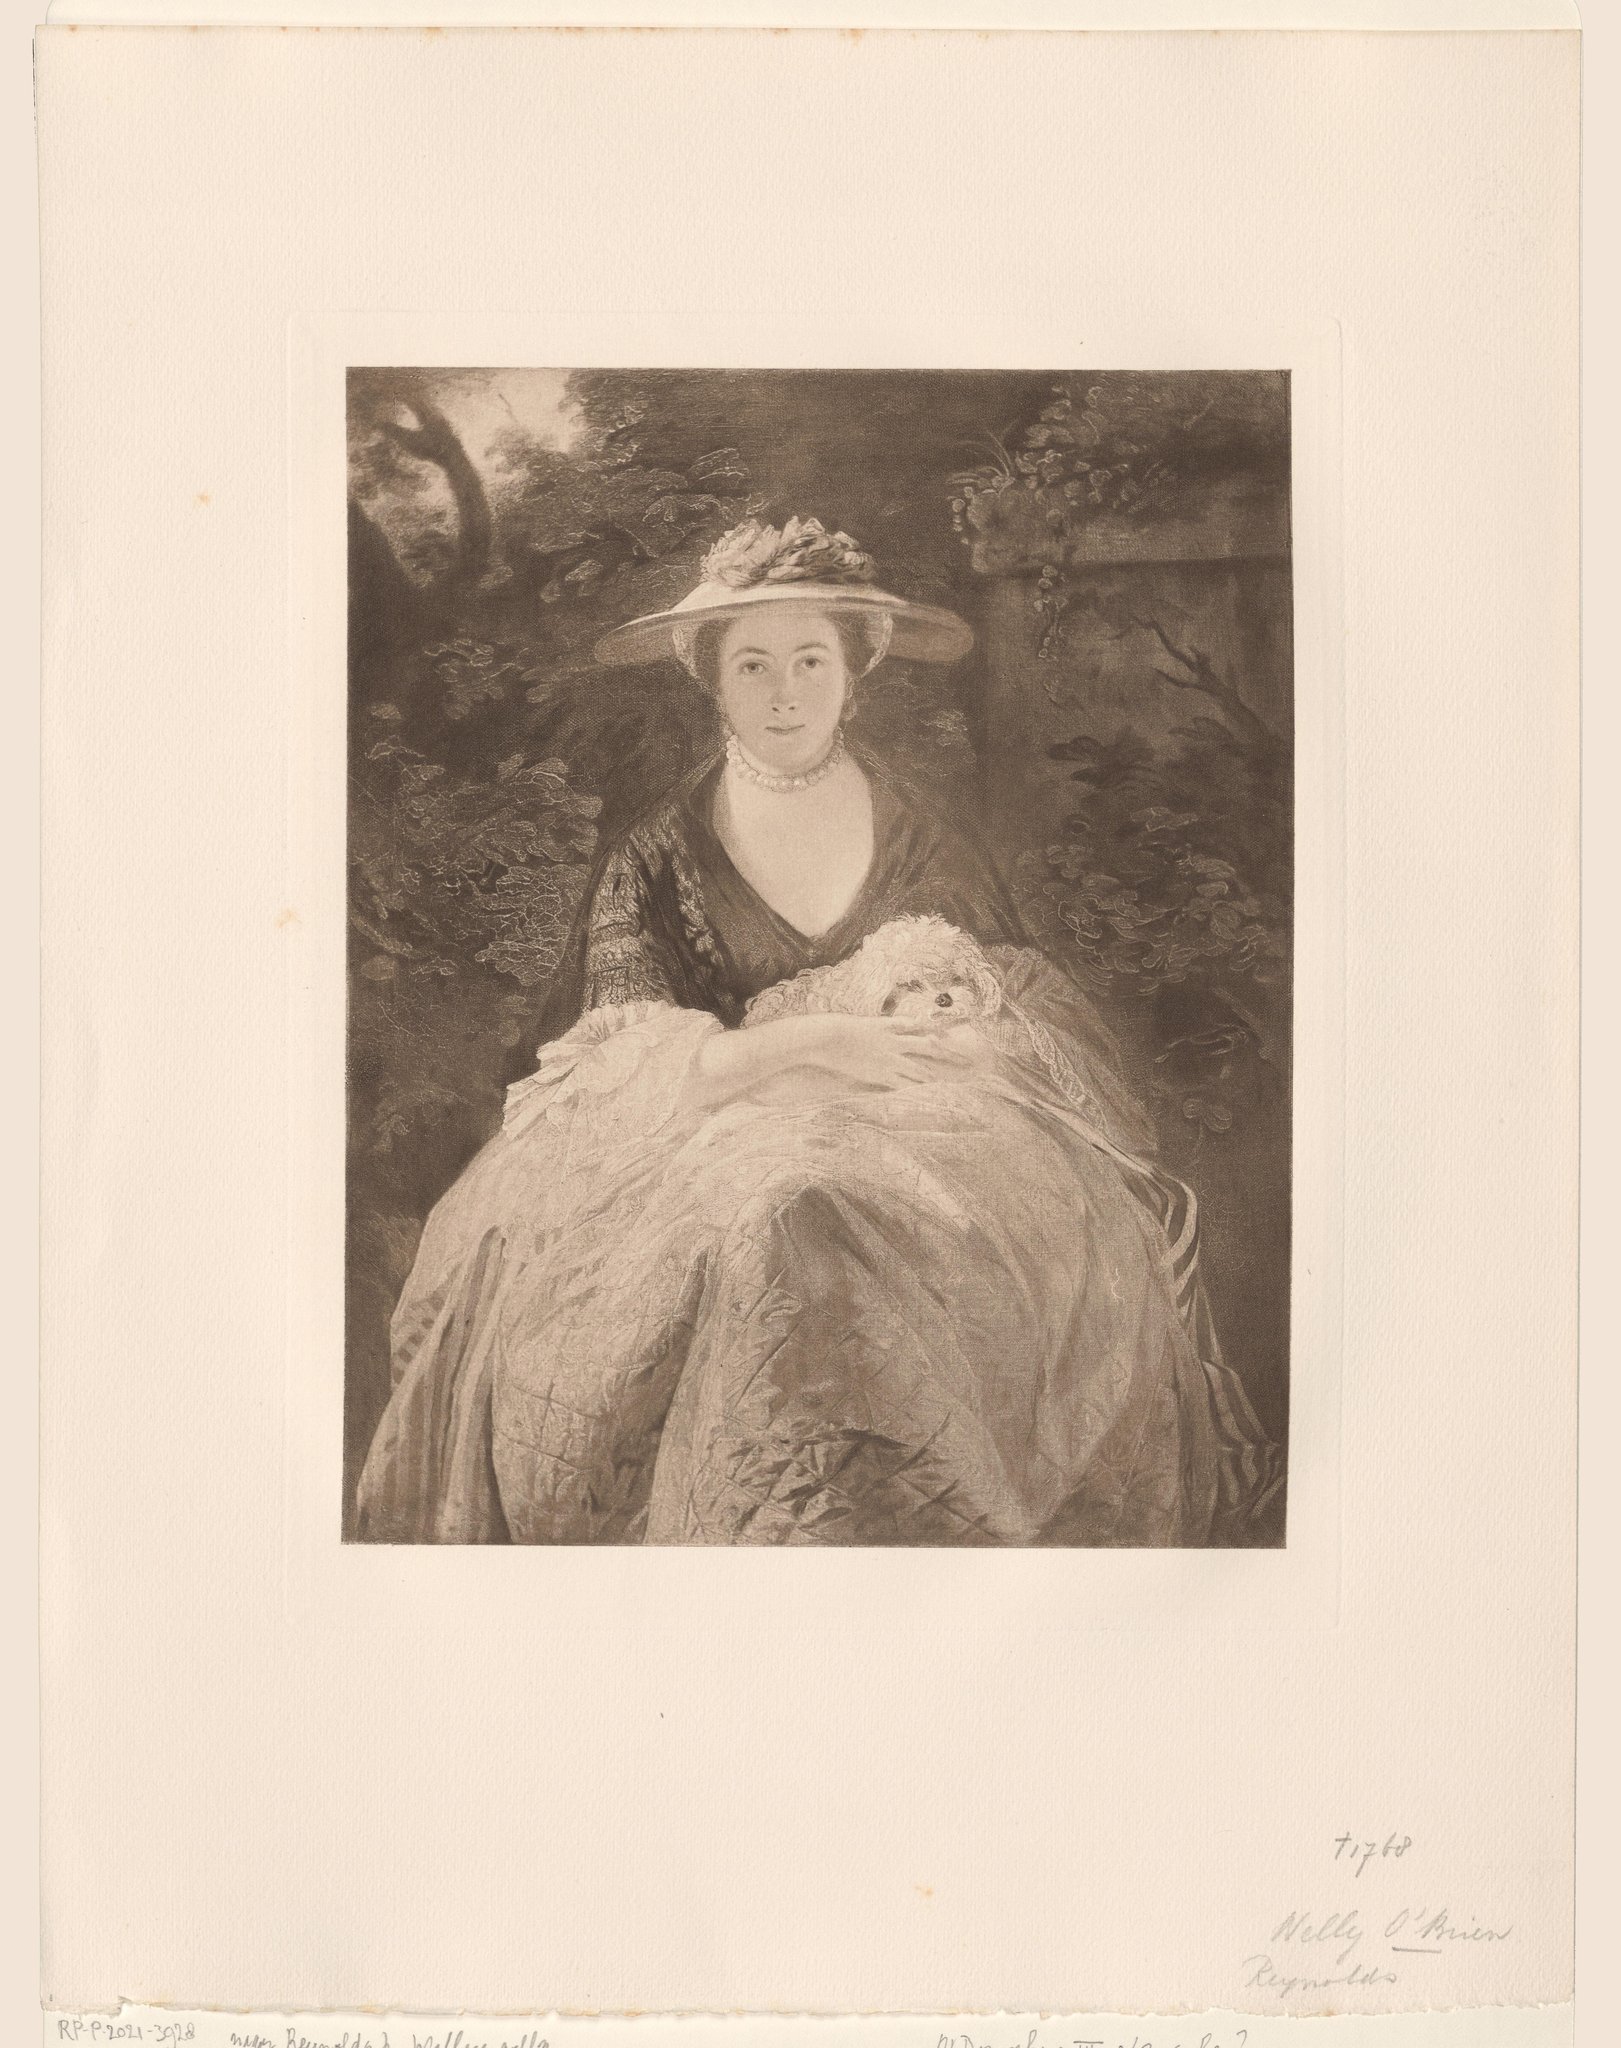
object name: print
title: Portret van Nelly O'Brien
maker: Anonymous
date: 1870-1915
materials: paper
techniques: photoaquatint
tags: historical persons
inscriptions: collector's mark: Lugt 2228